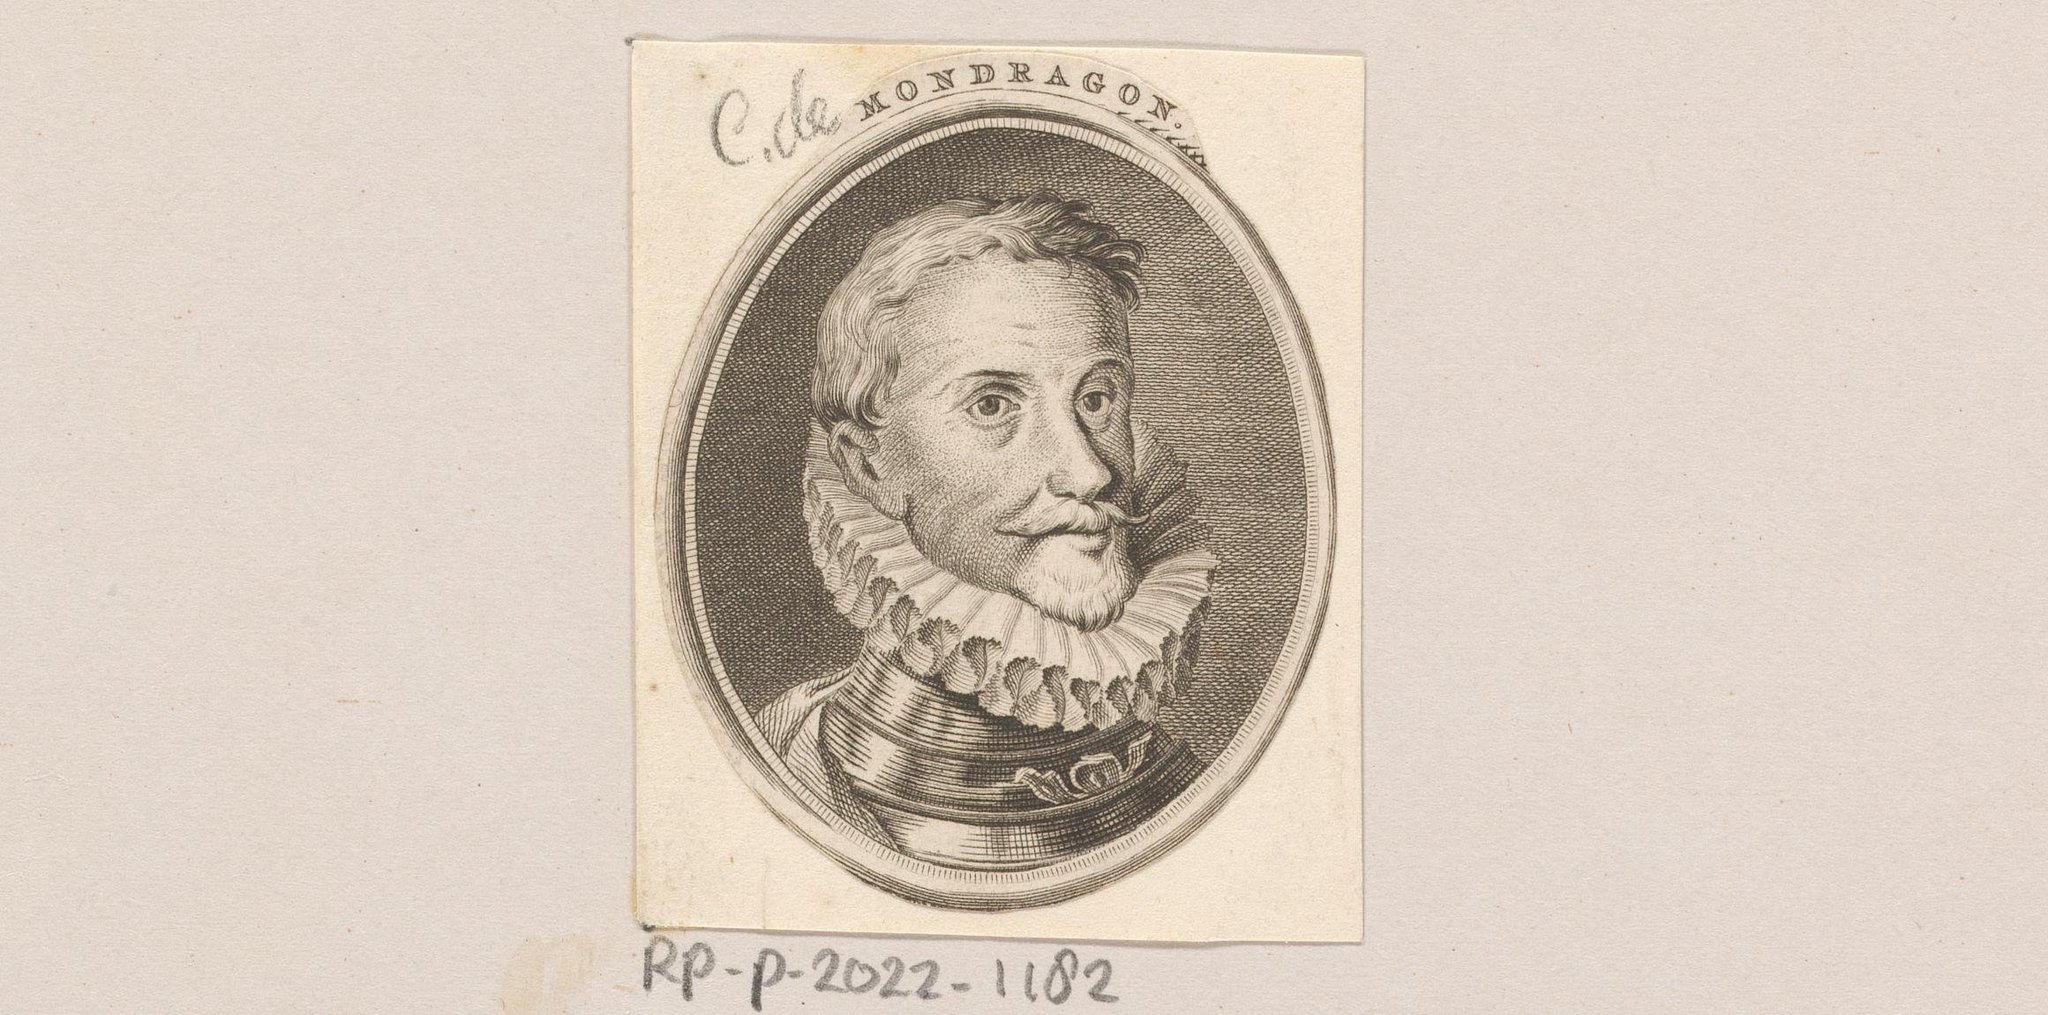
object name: print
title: Mondragon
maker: Anonymous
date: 1650-1800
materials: paper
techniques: engraving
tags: armour, historical persons